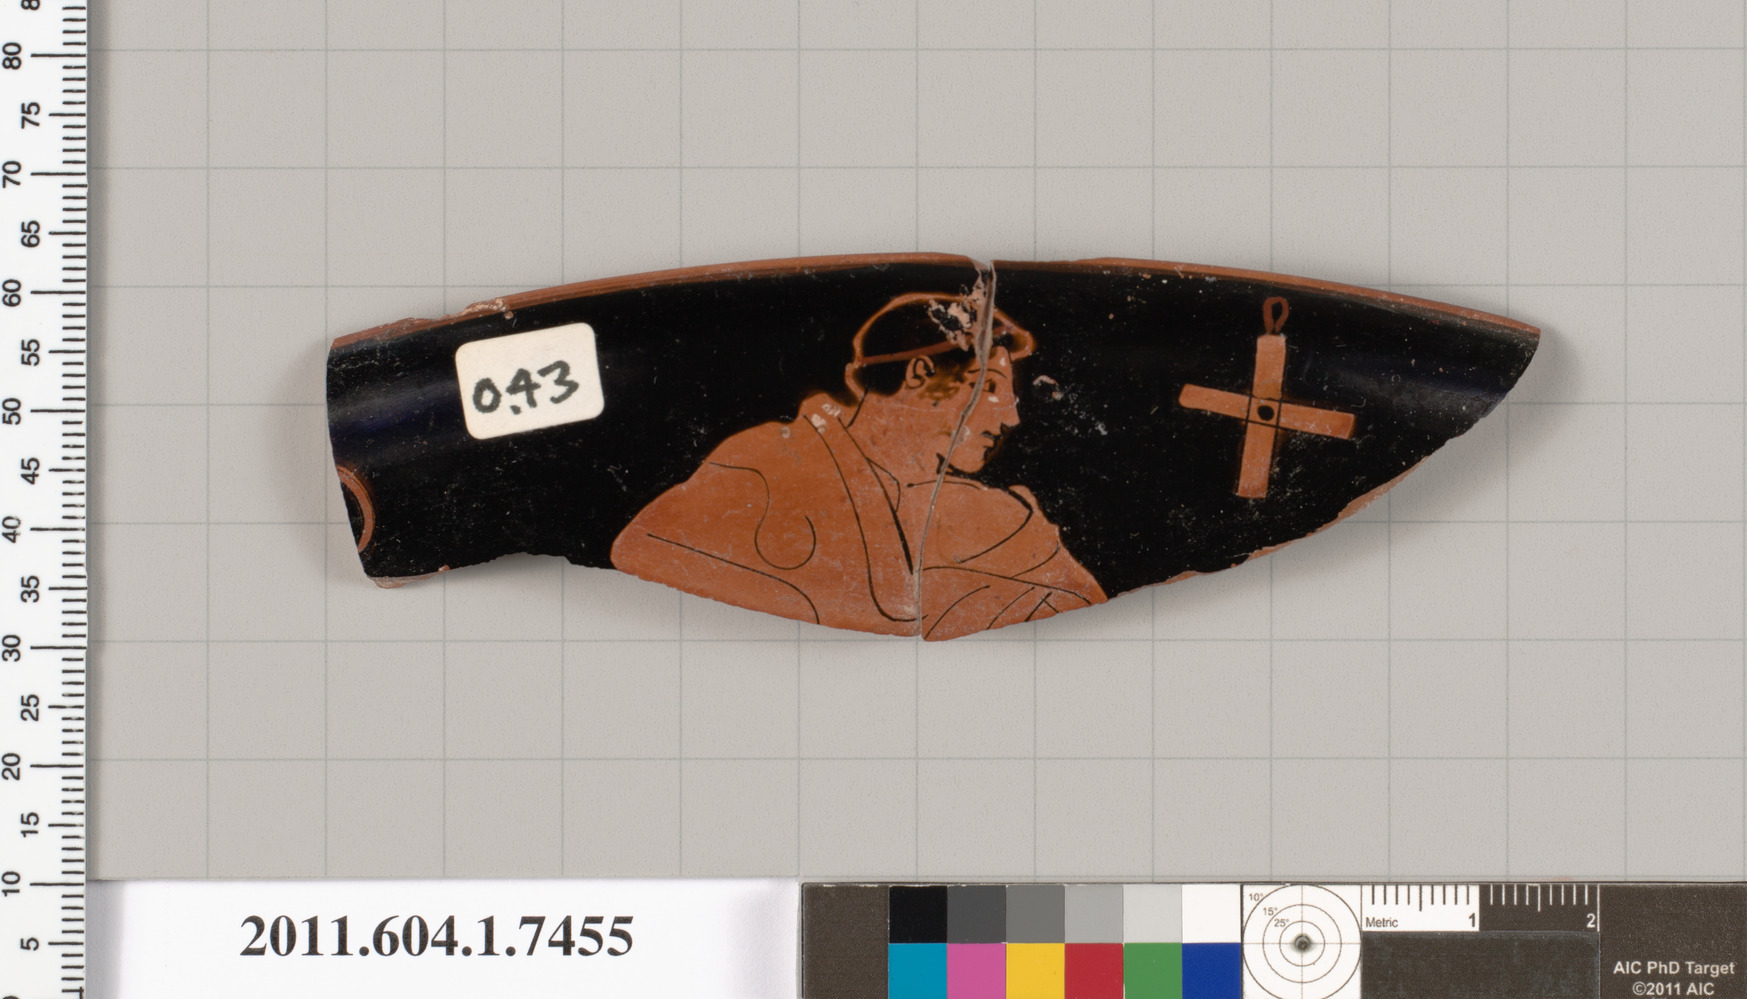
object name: kylix fragment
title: Terracotta fragment of a kylix (drinking cup)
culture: greek, attic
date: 470-460 BCE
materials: terracotta